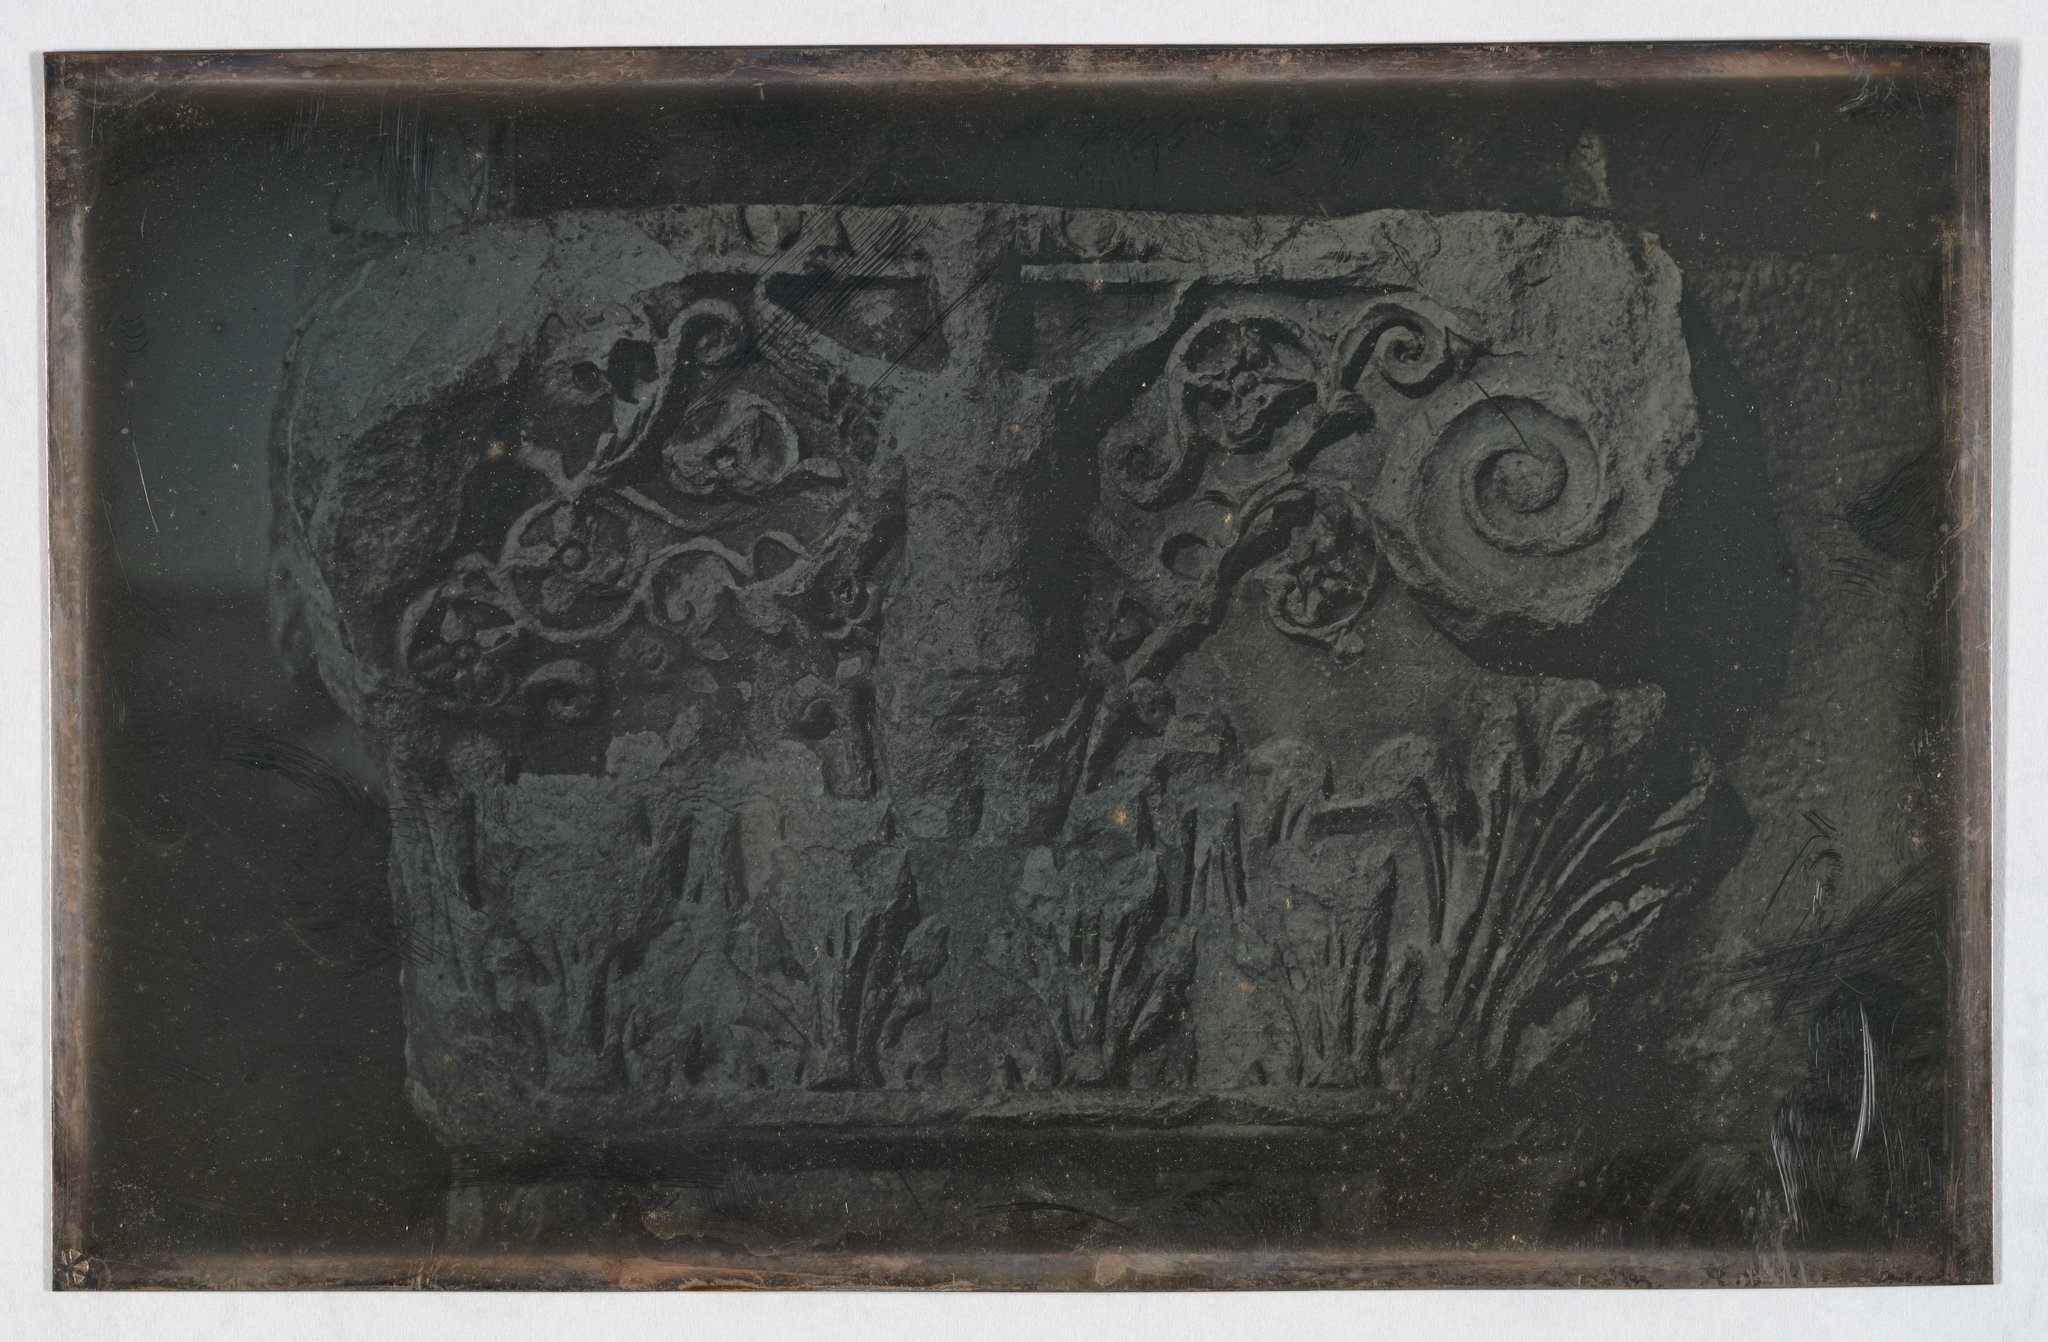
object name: daguerreotype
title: Capital, Greco-Roman Theater, Miletus (71. Milet. Théatre ant. chap.)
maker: joseph-philibert girault de prangey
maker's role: artist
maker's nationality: french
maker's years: 1804-1892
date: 1843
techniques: daguerreotype